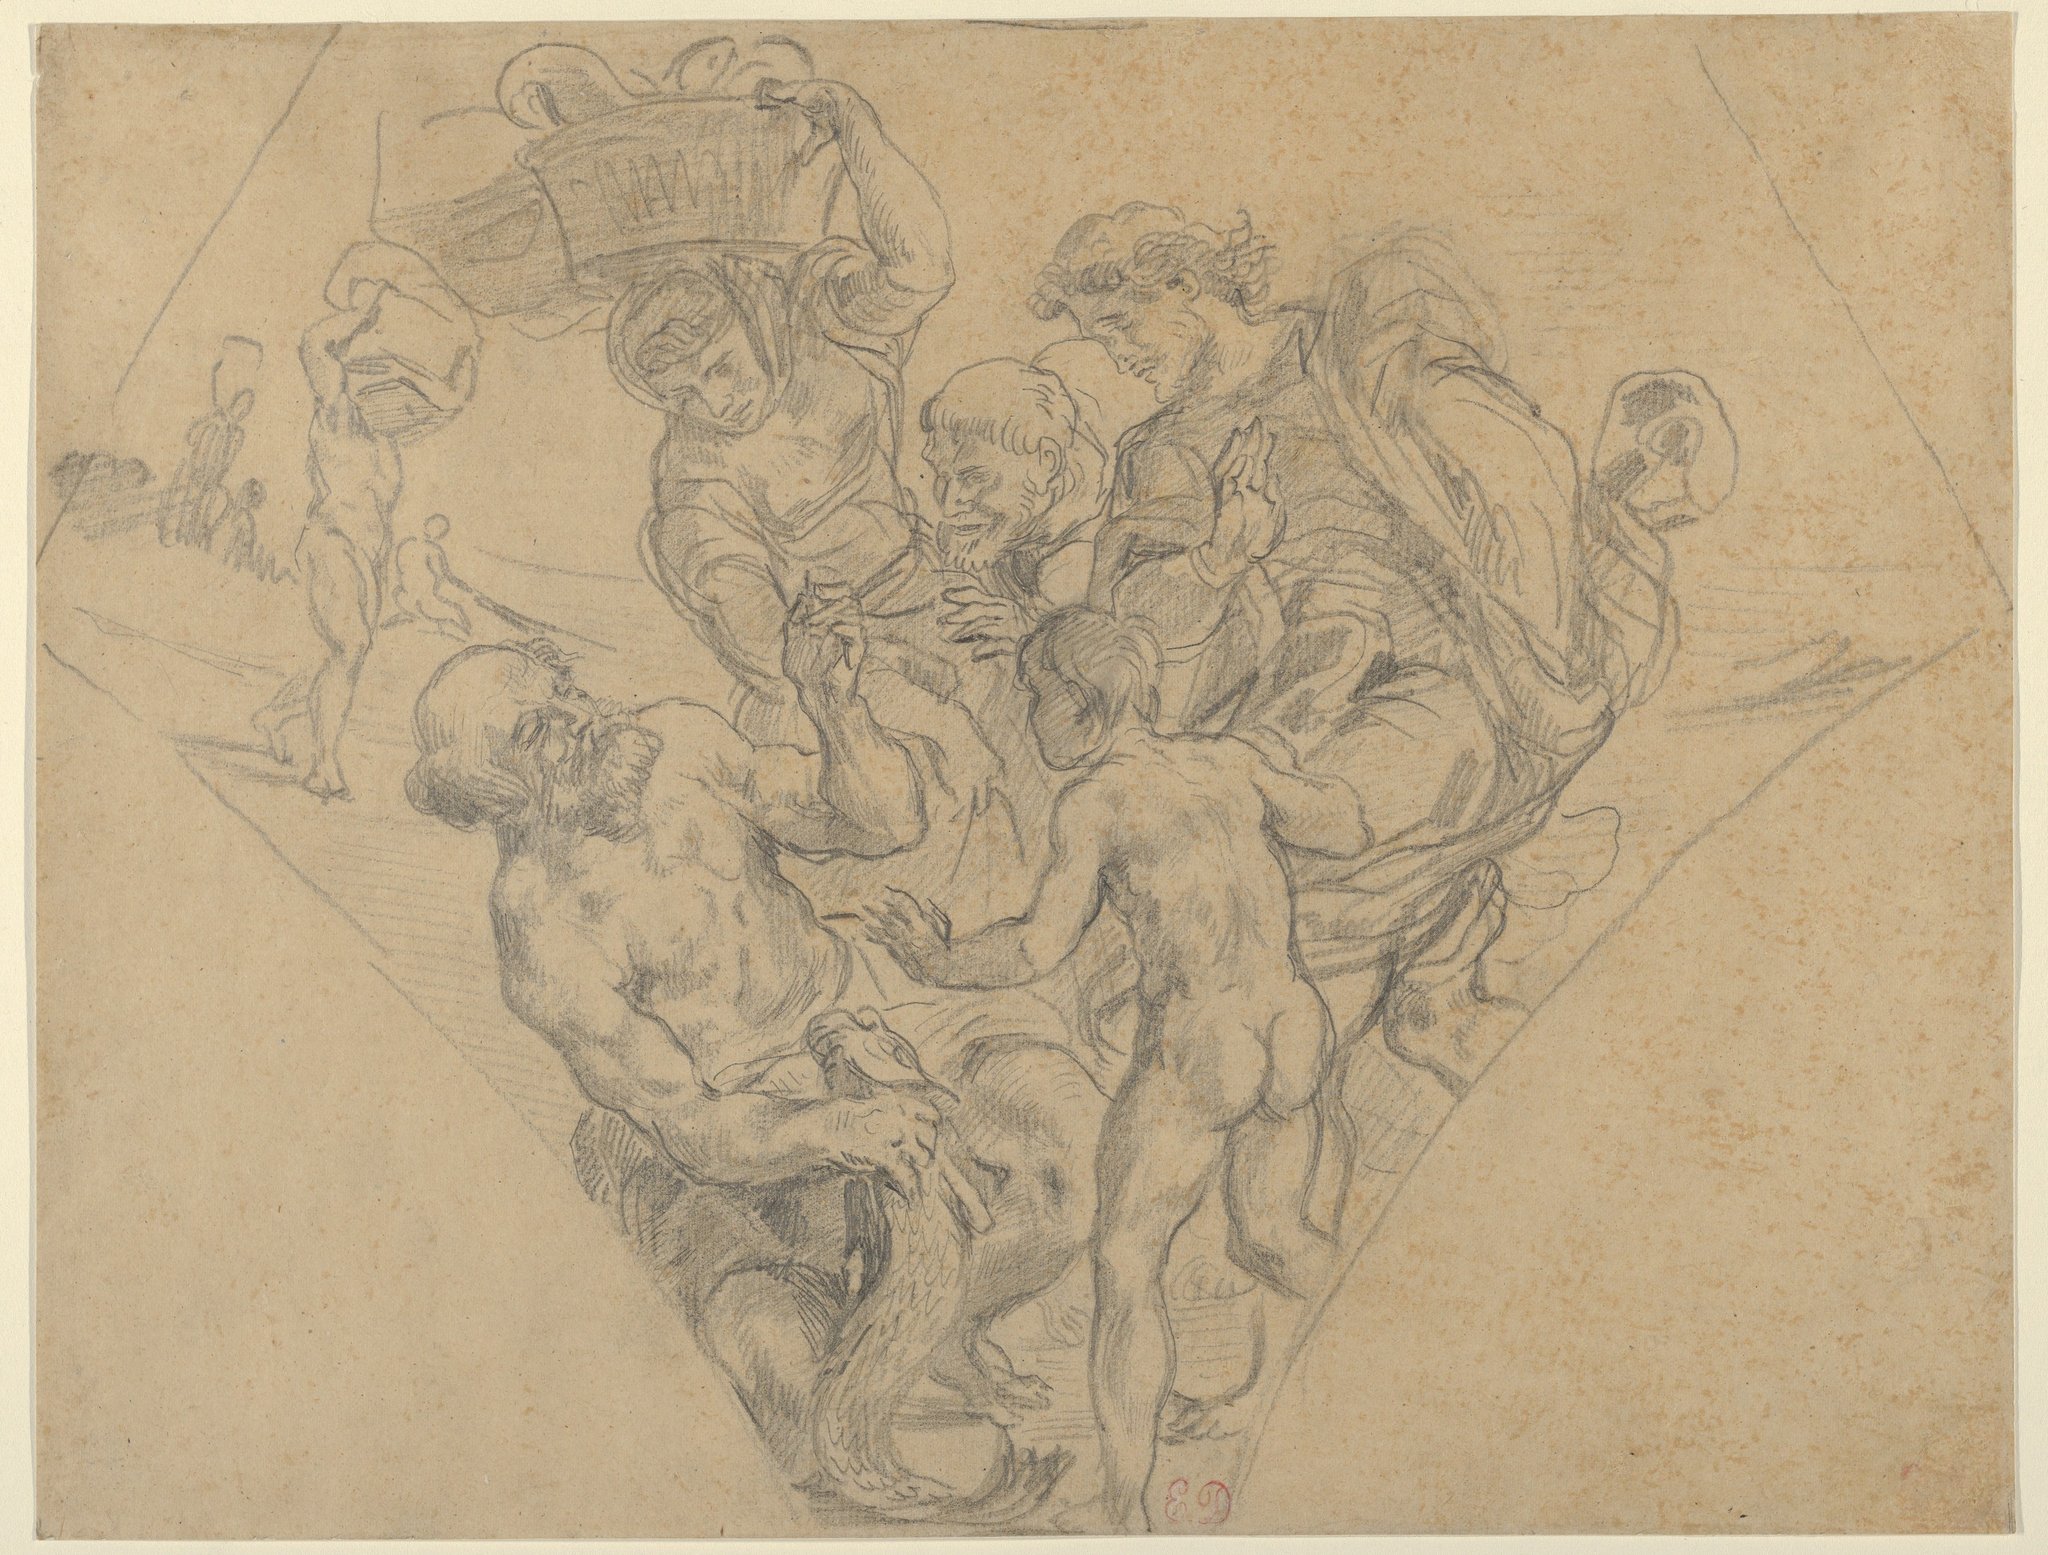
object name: drawing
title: The Tribute Money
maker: eugène delacroix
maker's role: artist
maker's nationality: french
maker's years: 1798-1863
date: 1843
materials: graphite, paper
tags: boys,men,fish